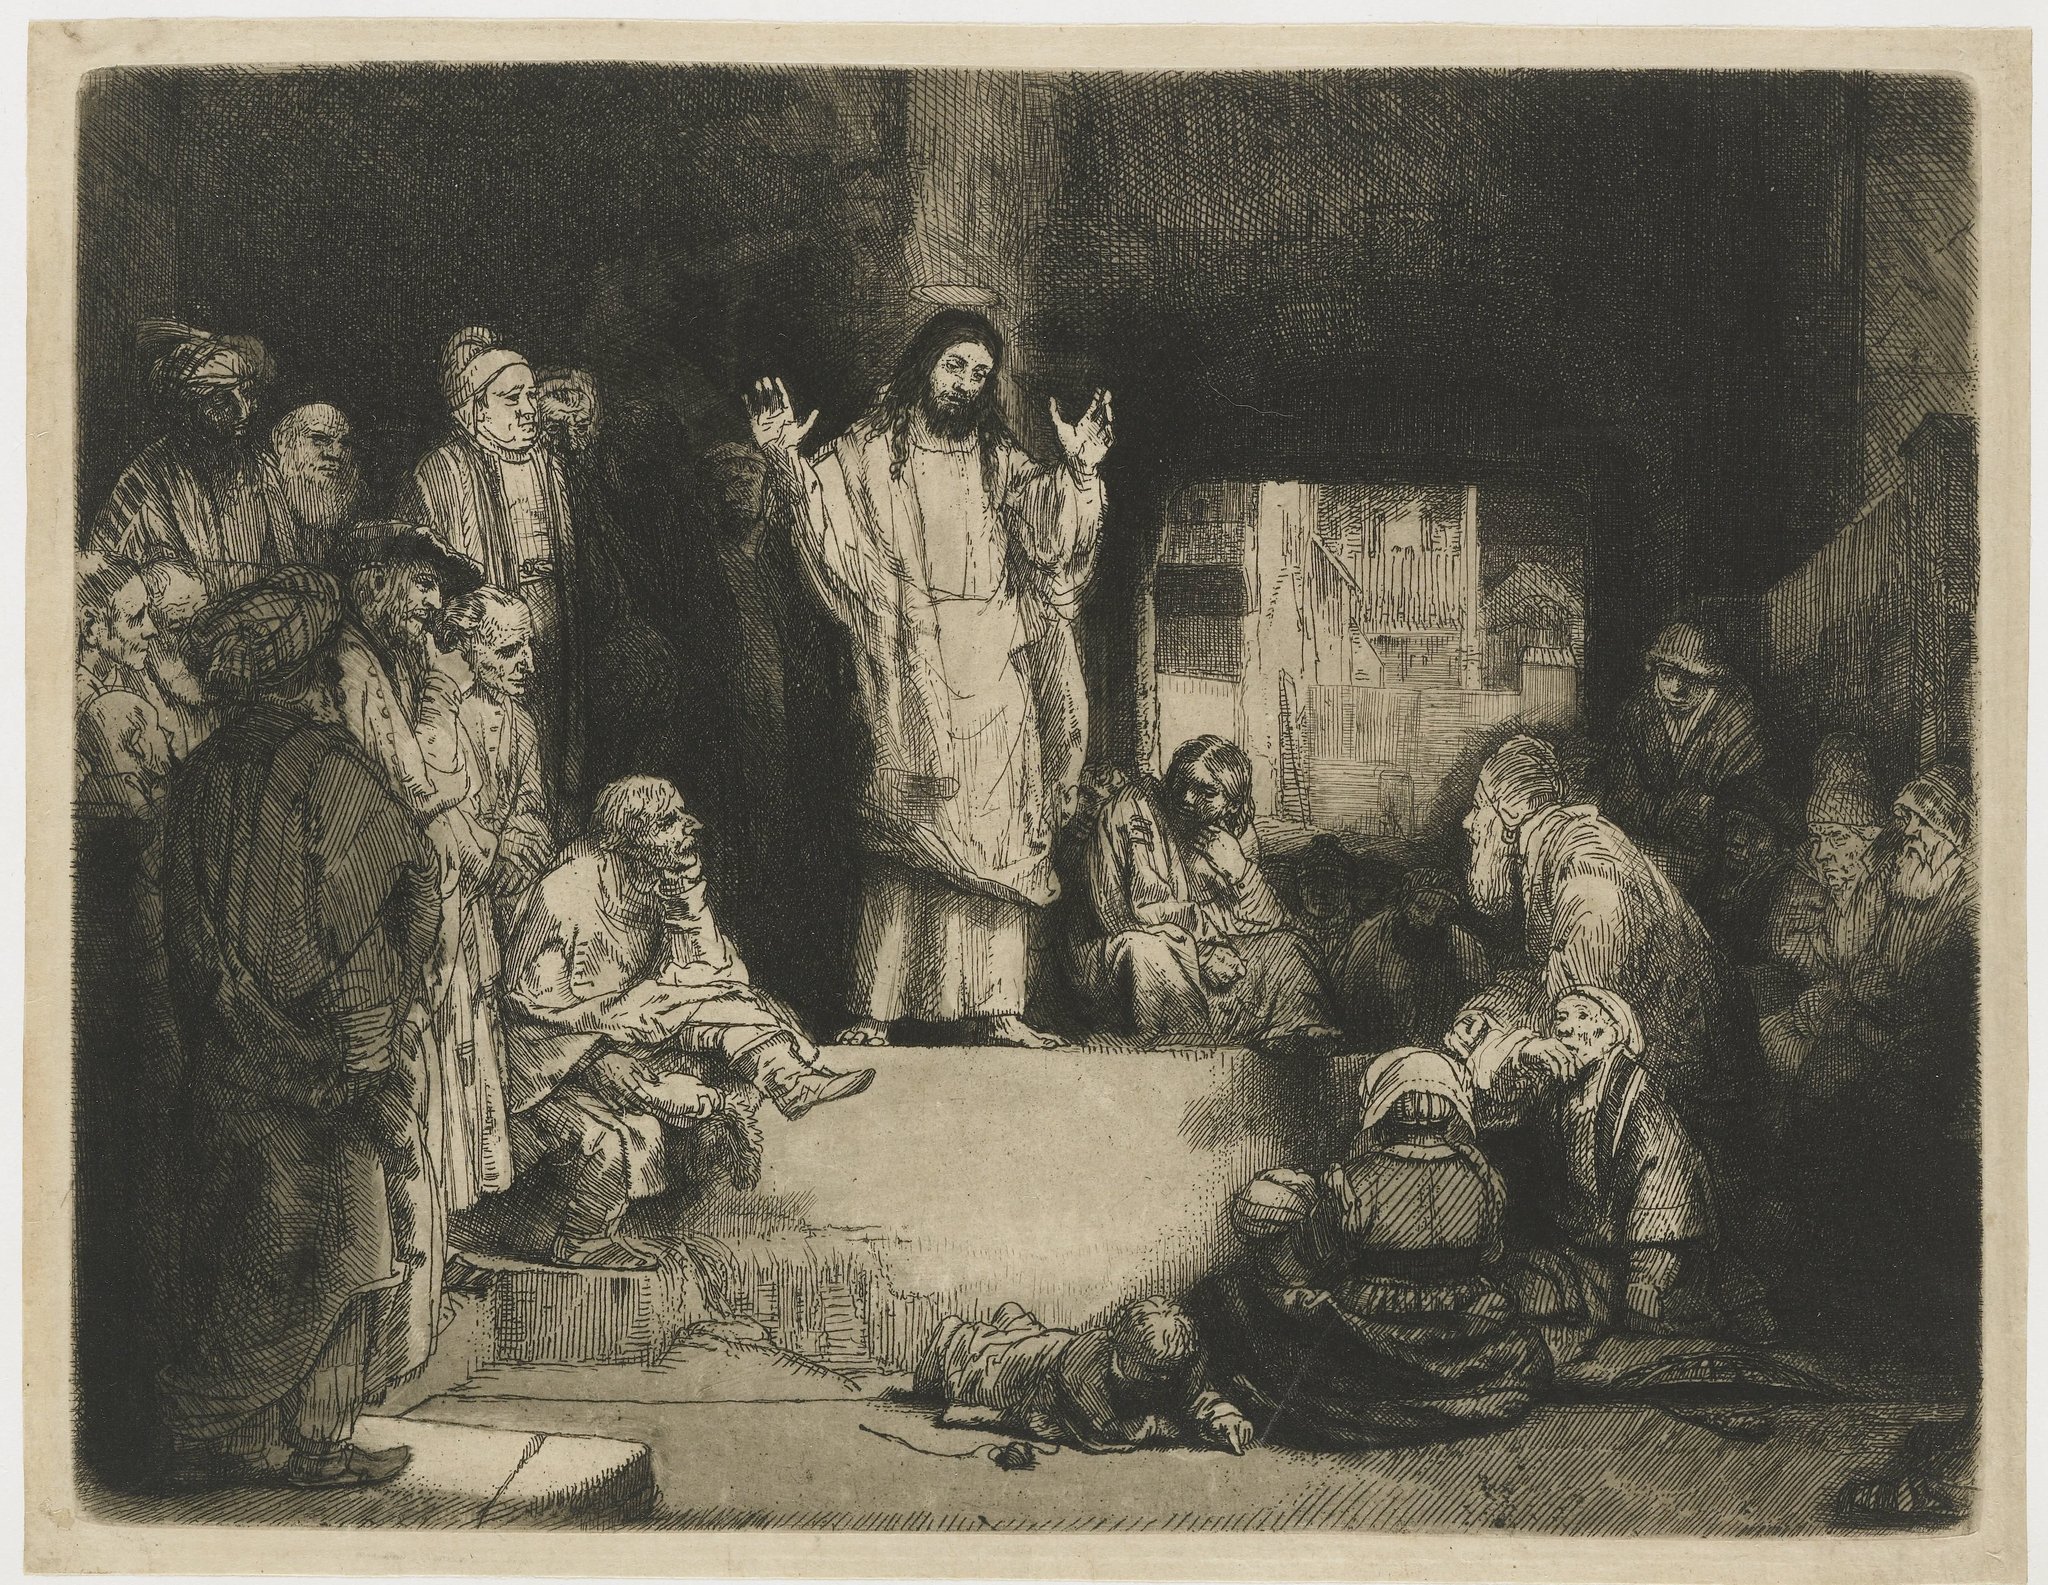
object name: print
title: Christ preaching ('La Petite Tombe')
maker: rembrandt van rijn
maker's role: draughtsman, painter, print maker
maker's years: 1606-1669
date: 1657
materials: paper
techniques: brush, drypoint, etching, intaglio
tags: christ preaching or teaching (in general)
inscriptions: inscription: ‘(V?)aartuygen’, collector's mark: Lugt 240